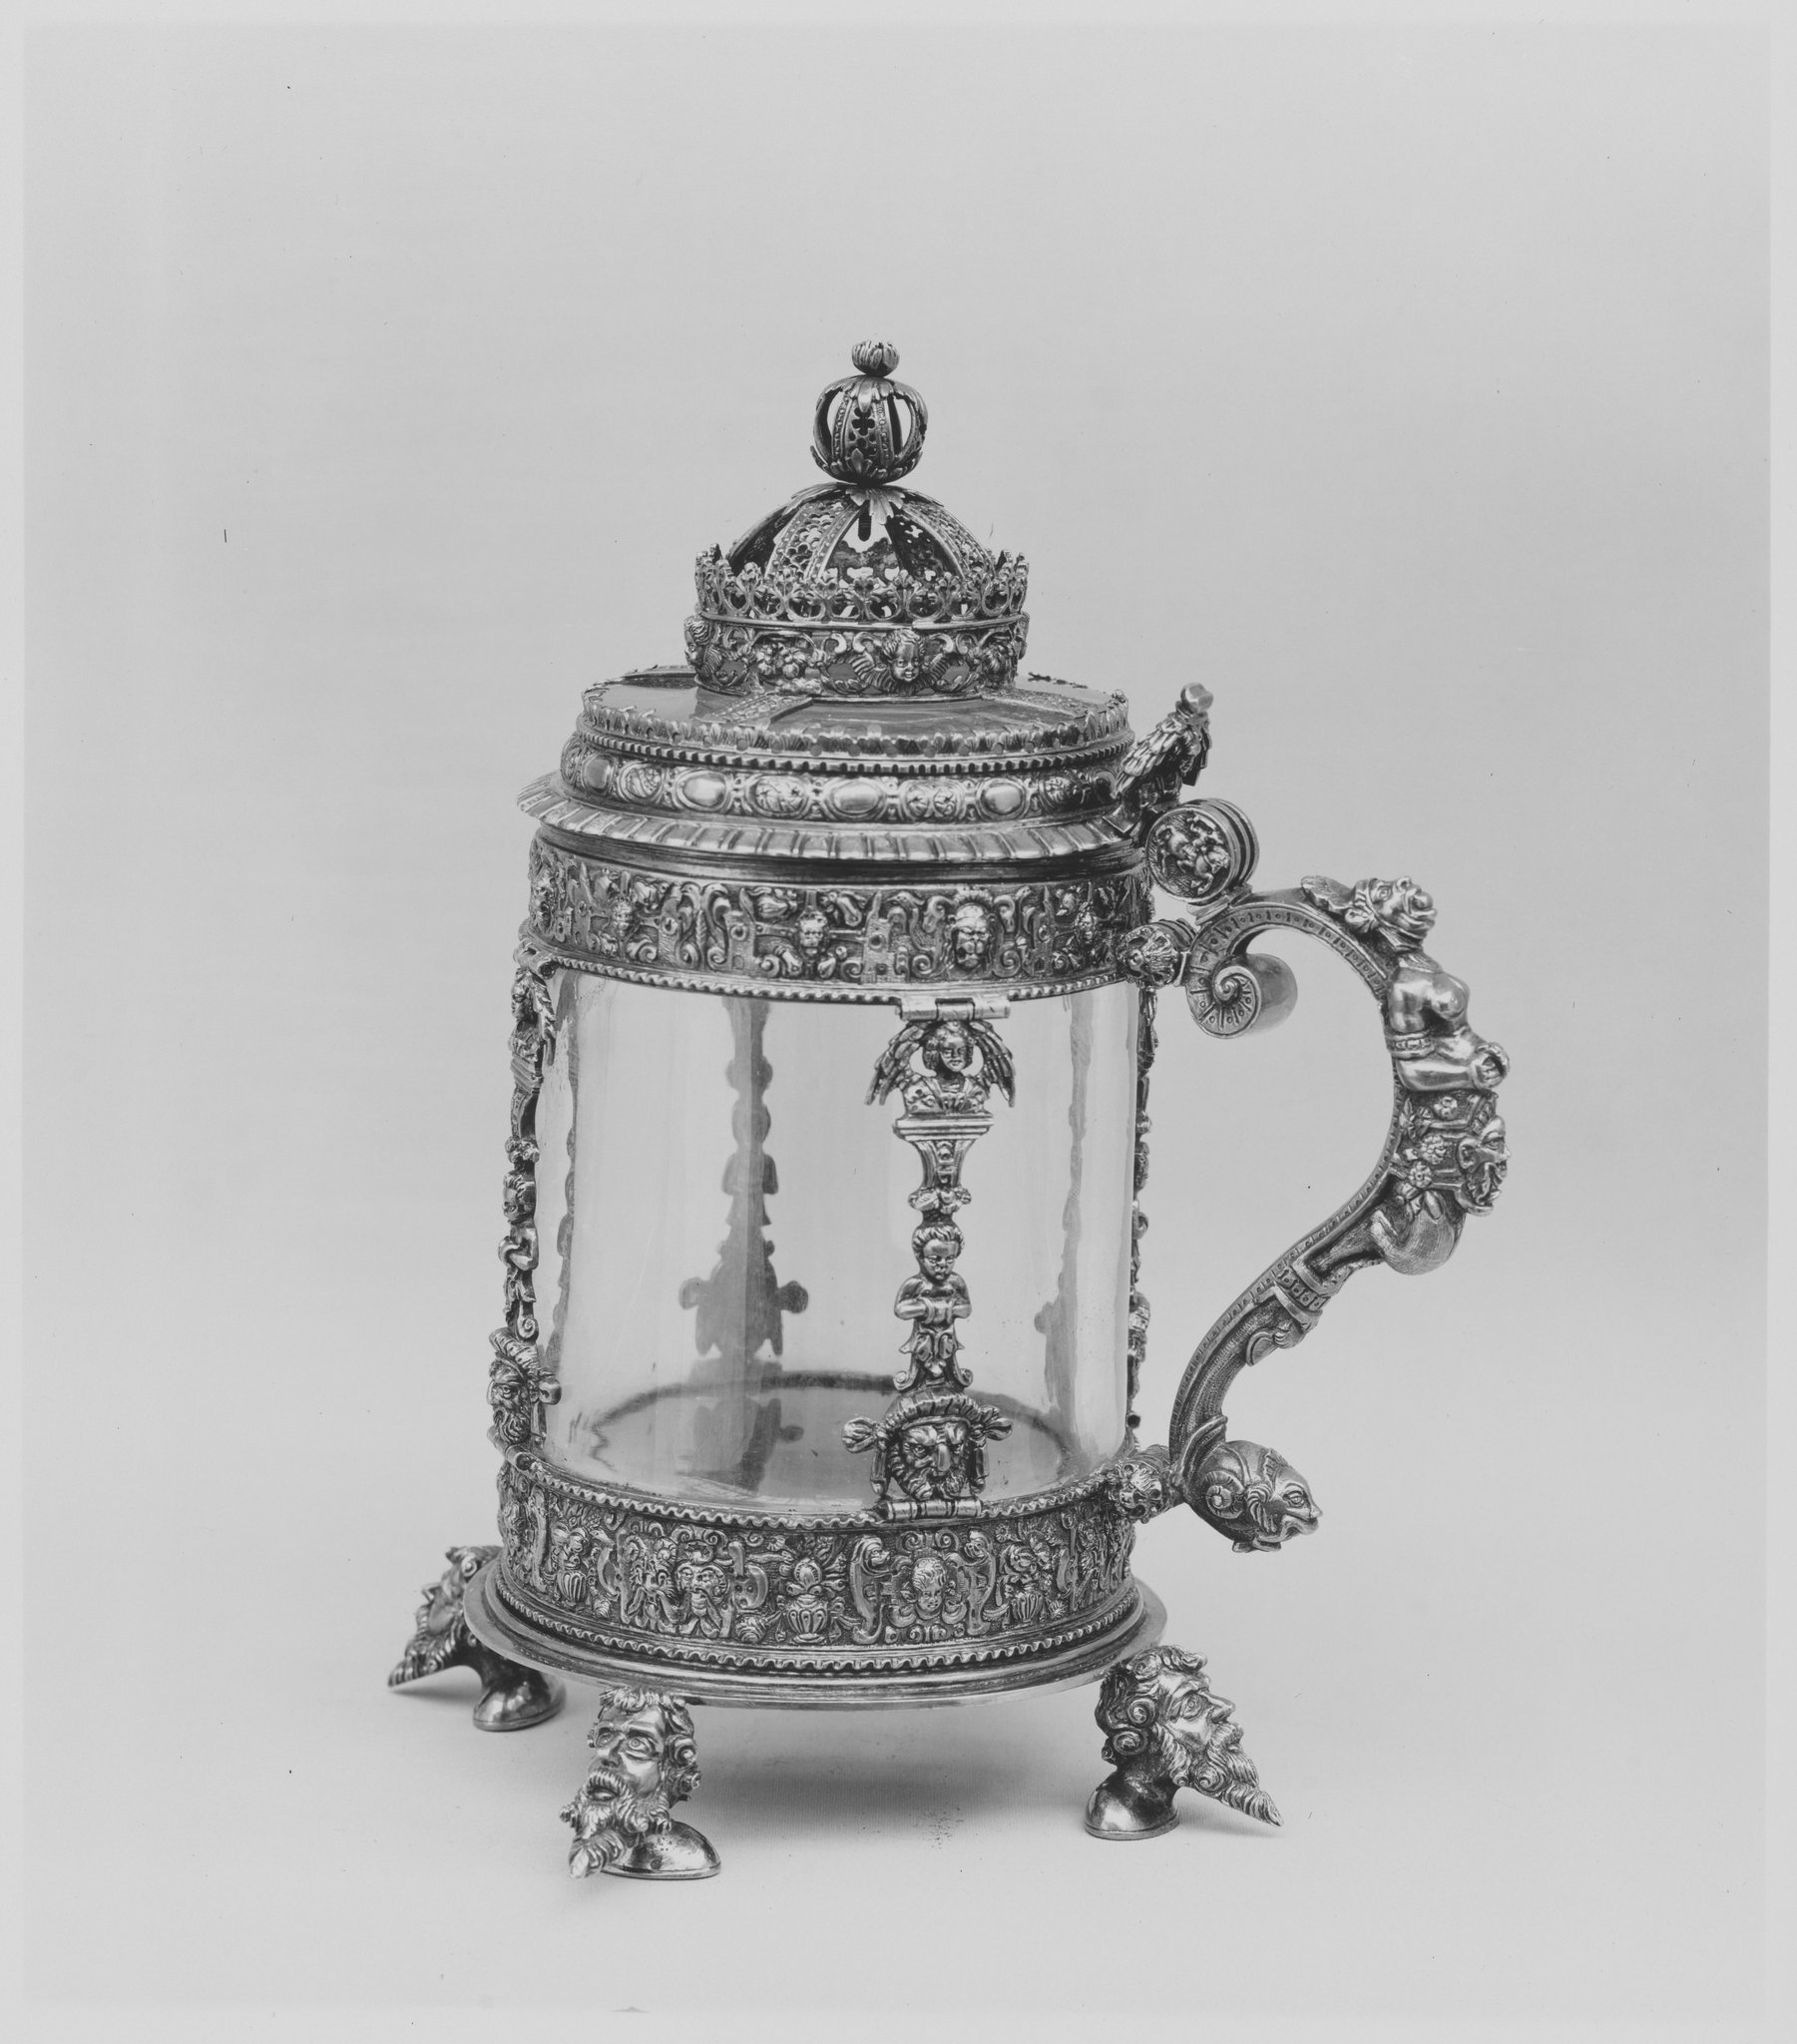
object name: tankard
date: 1801-1900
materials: quartz, silver gilt